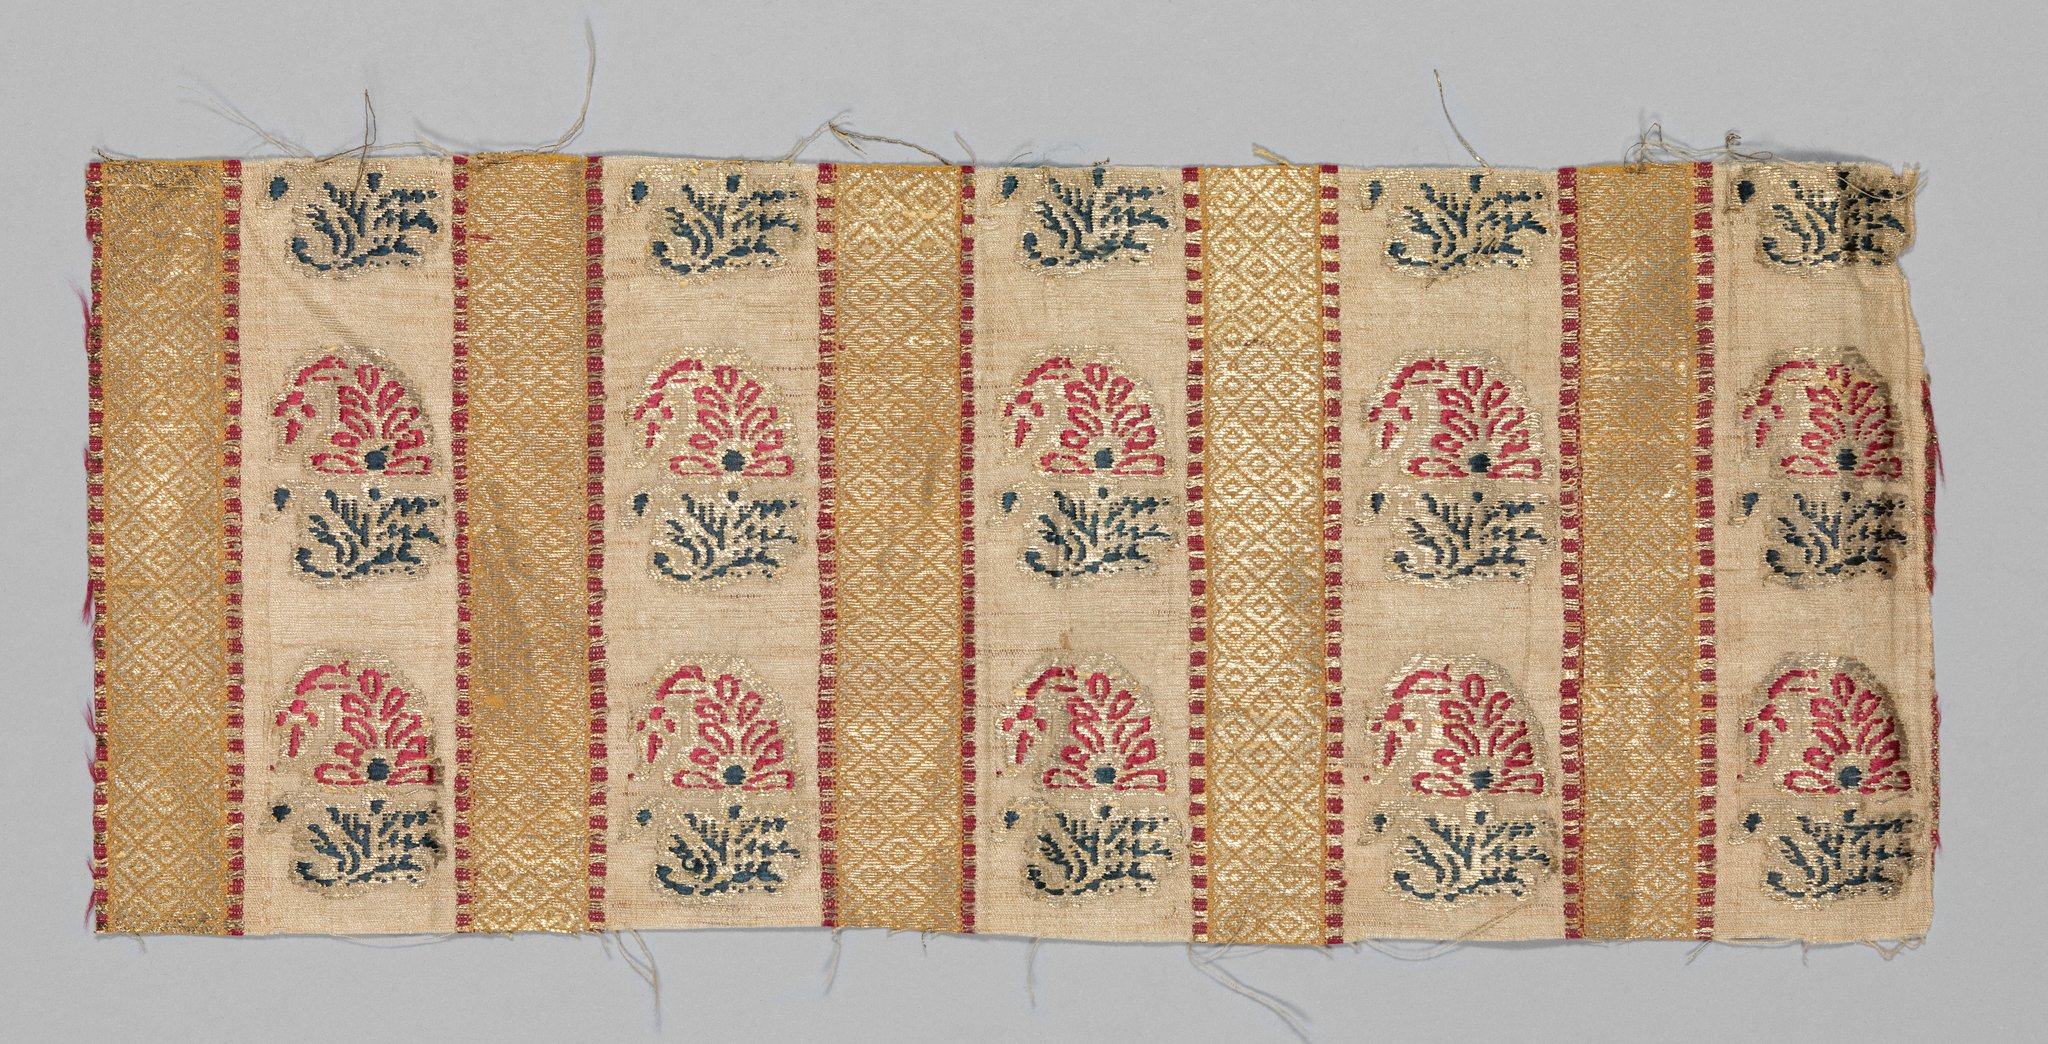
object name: textile fragment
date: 1701-1800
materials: metal thread, silk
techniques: brocade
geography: india